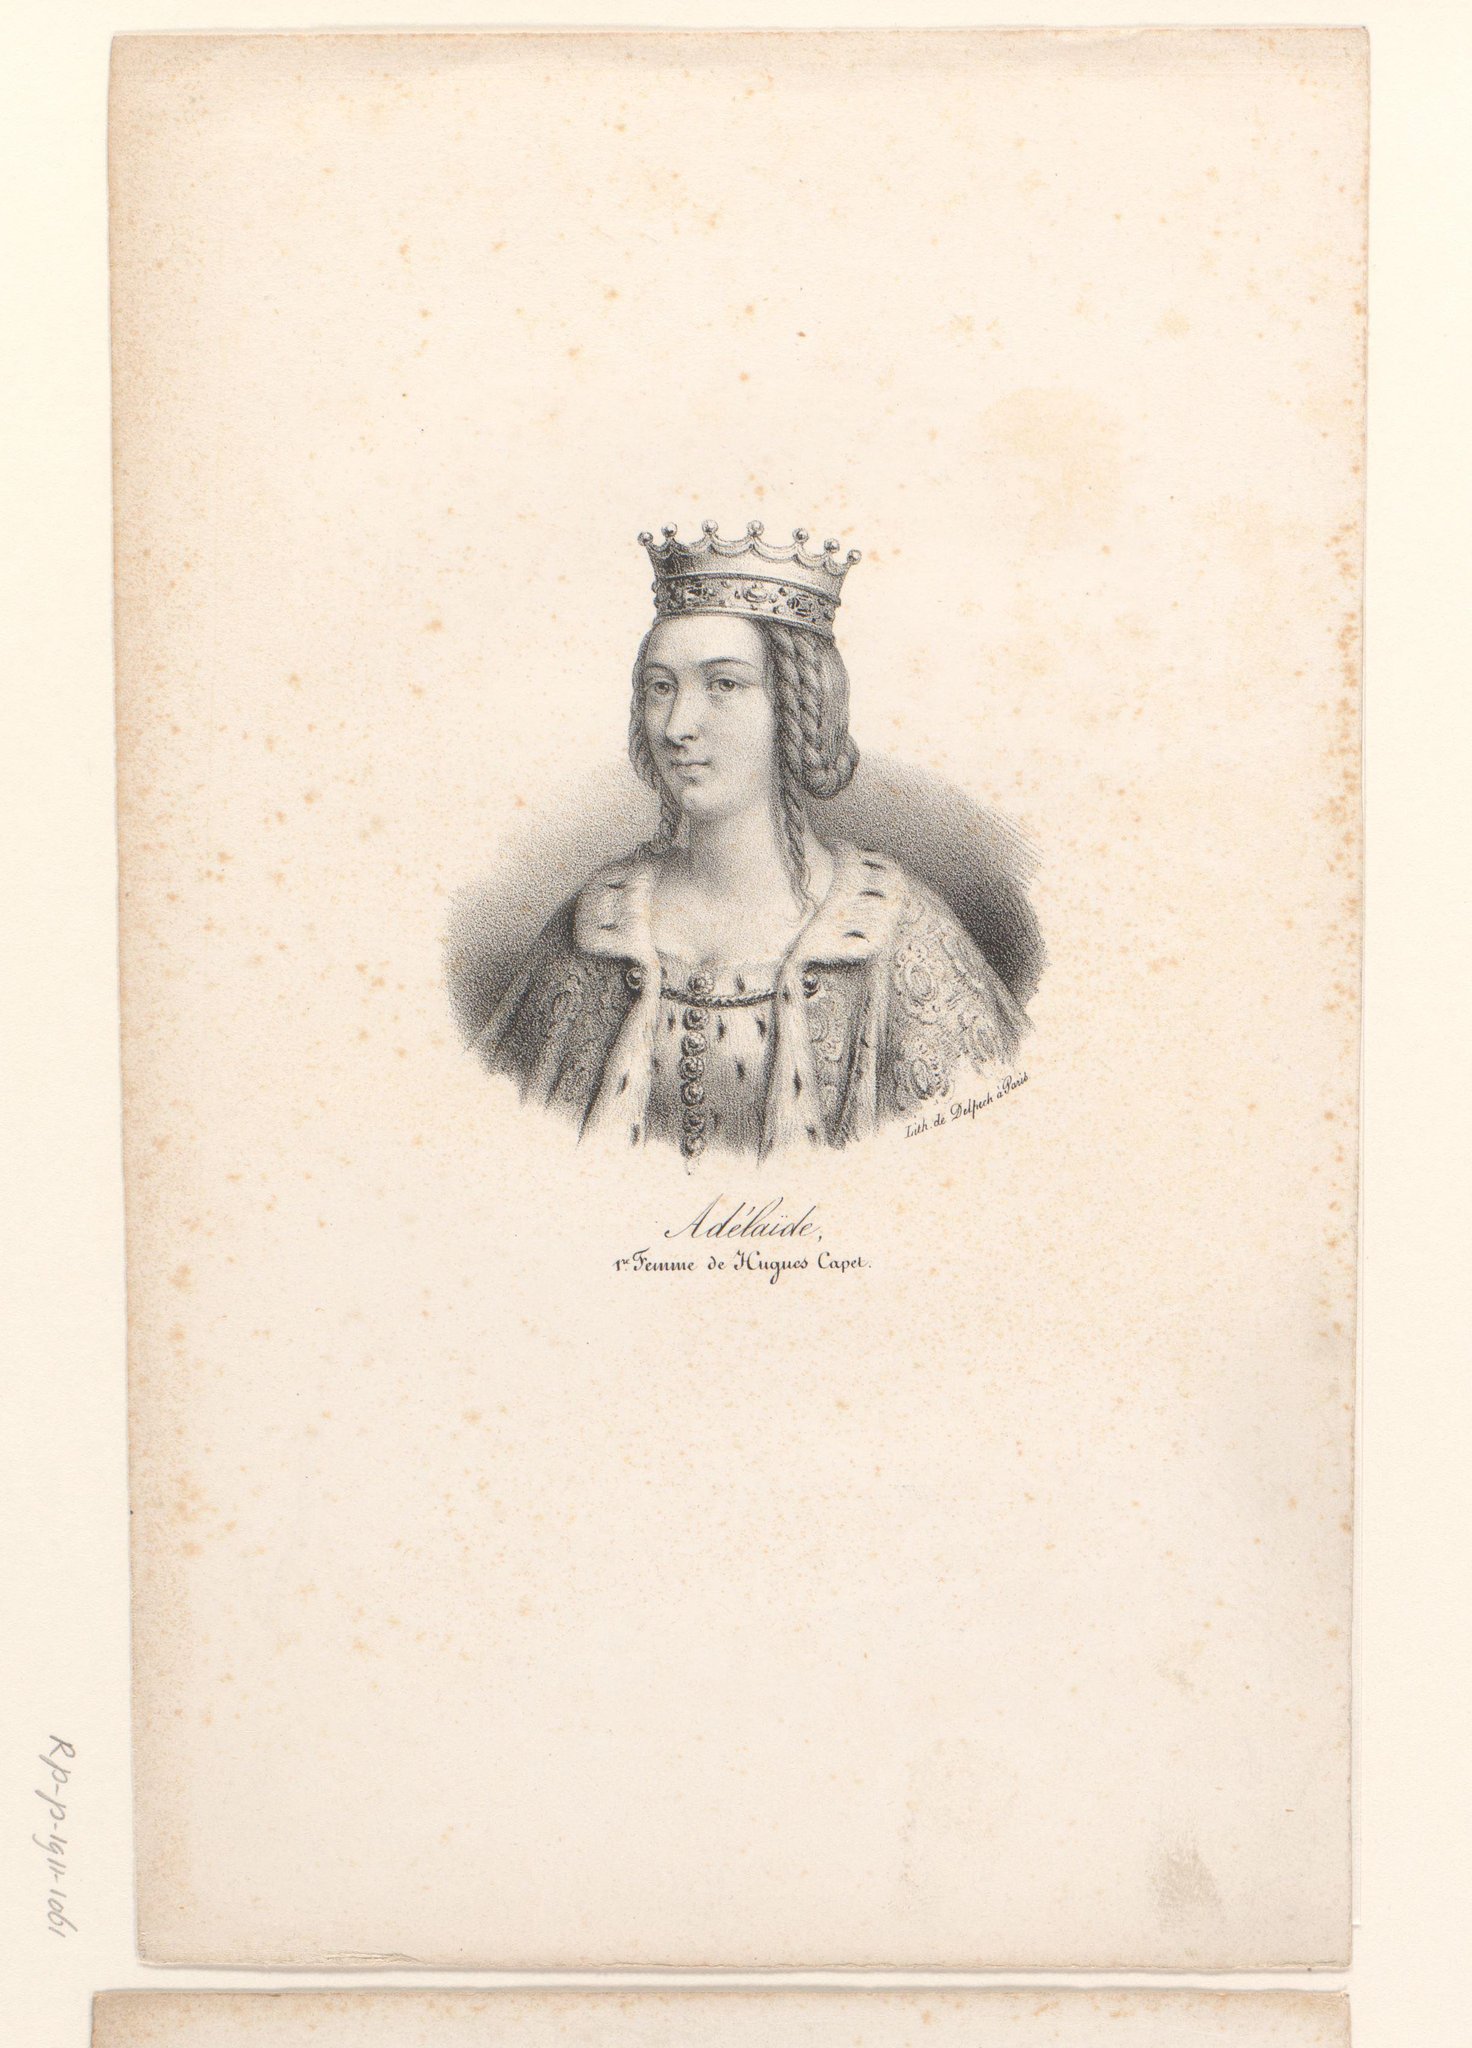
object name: print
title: Portret van Adelheid van Poitiers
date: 1818-1842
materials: paper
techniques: lithograph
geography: paris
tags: historical persons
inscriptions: collector's mark: Lugt 2228a